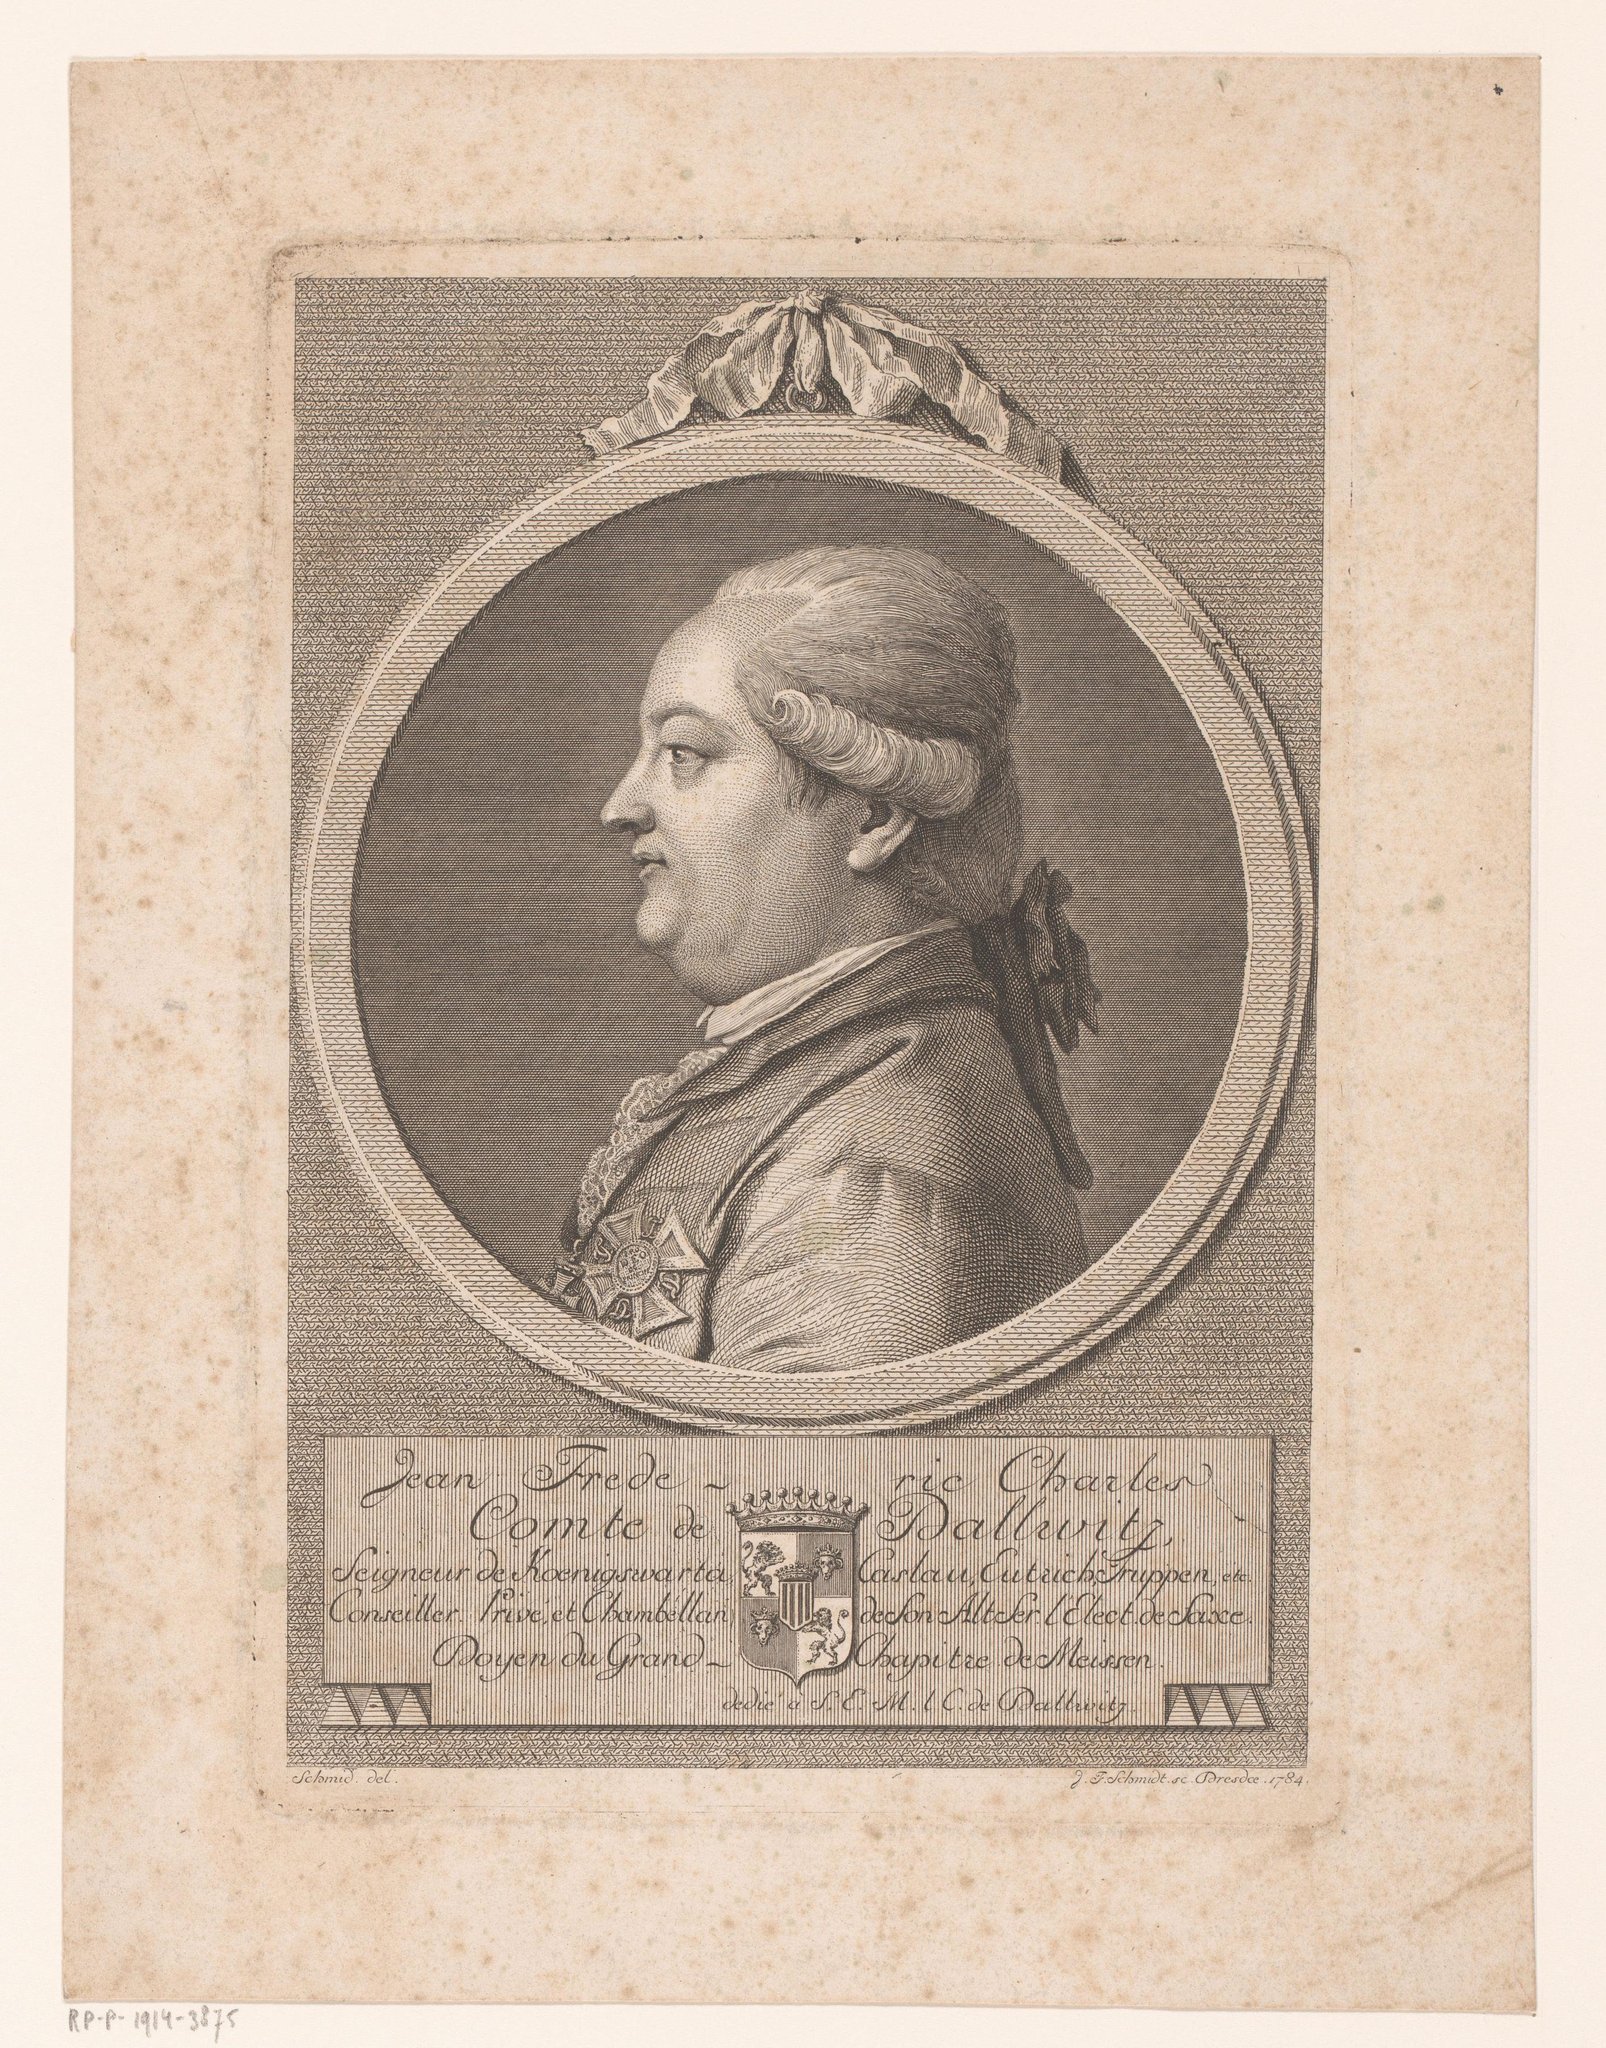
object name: print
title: Portret van Johann Carl Friedrich von Dallwitz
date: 1757-1765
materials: paper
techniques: engraving, etching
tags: earl, historical persons, armorial bearing, heraldry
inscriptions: collector's mark: Lugt 2228